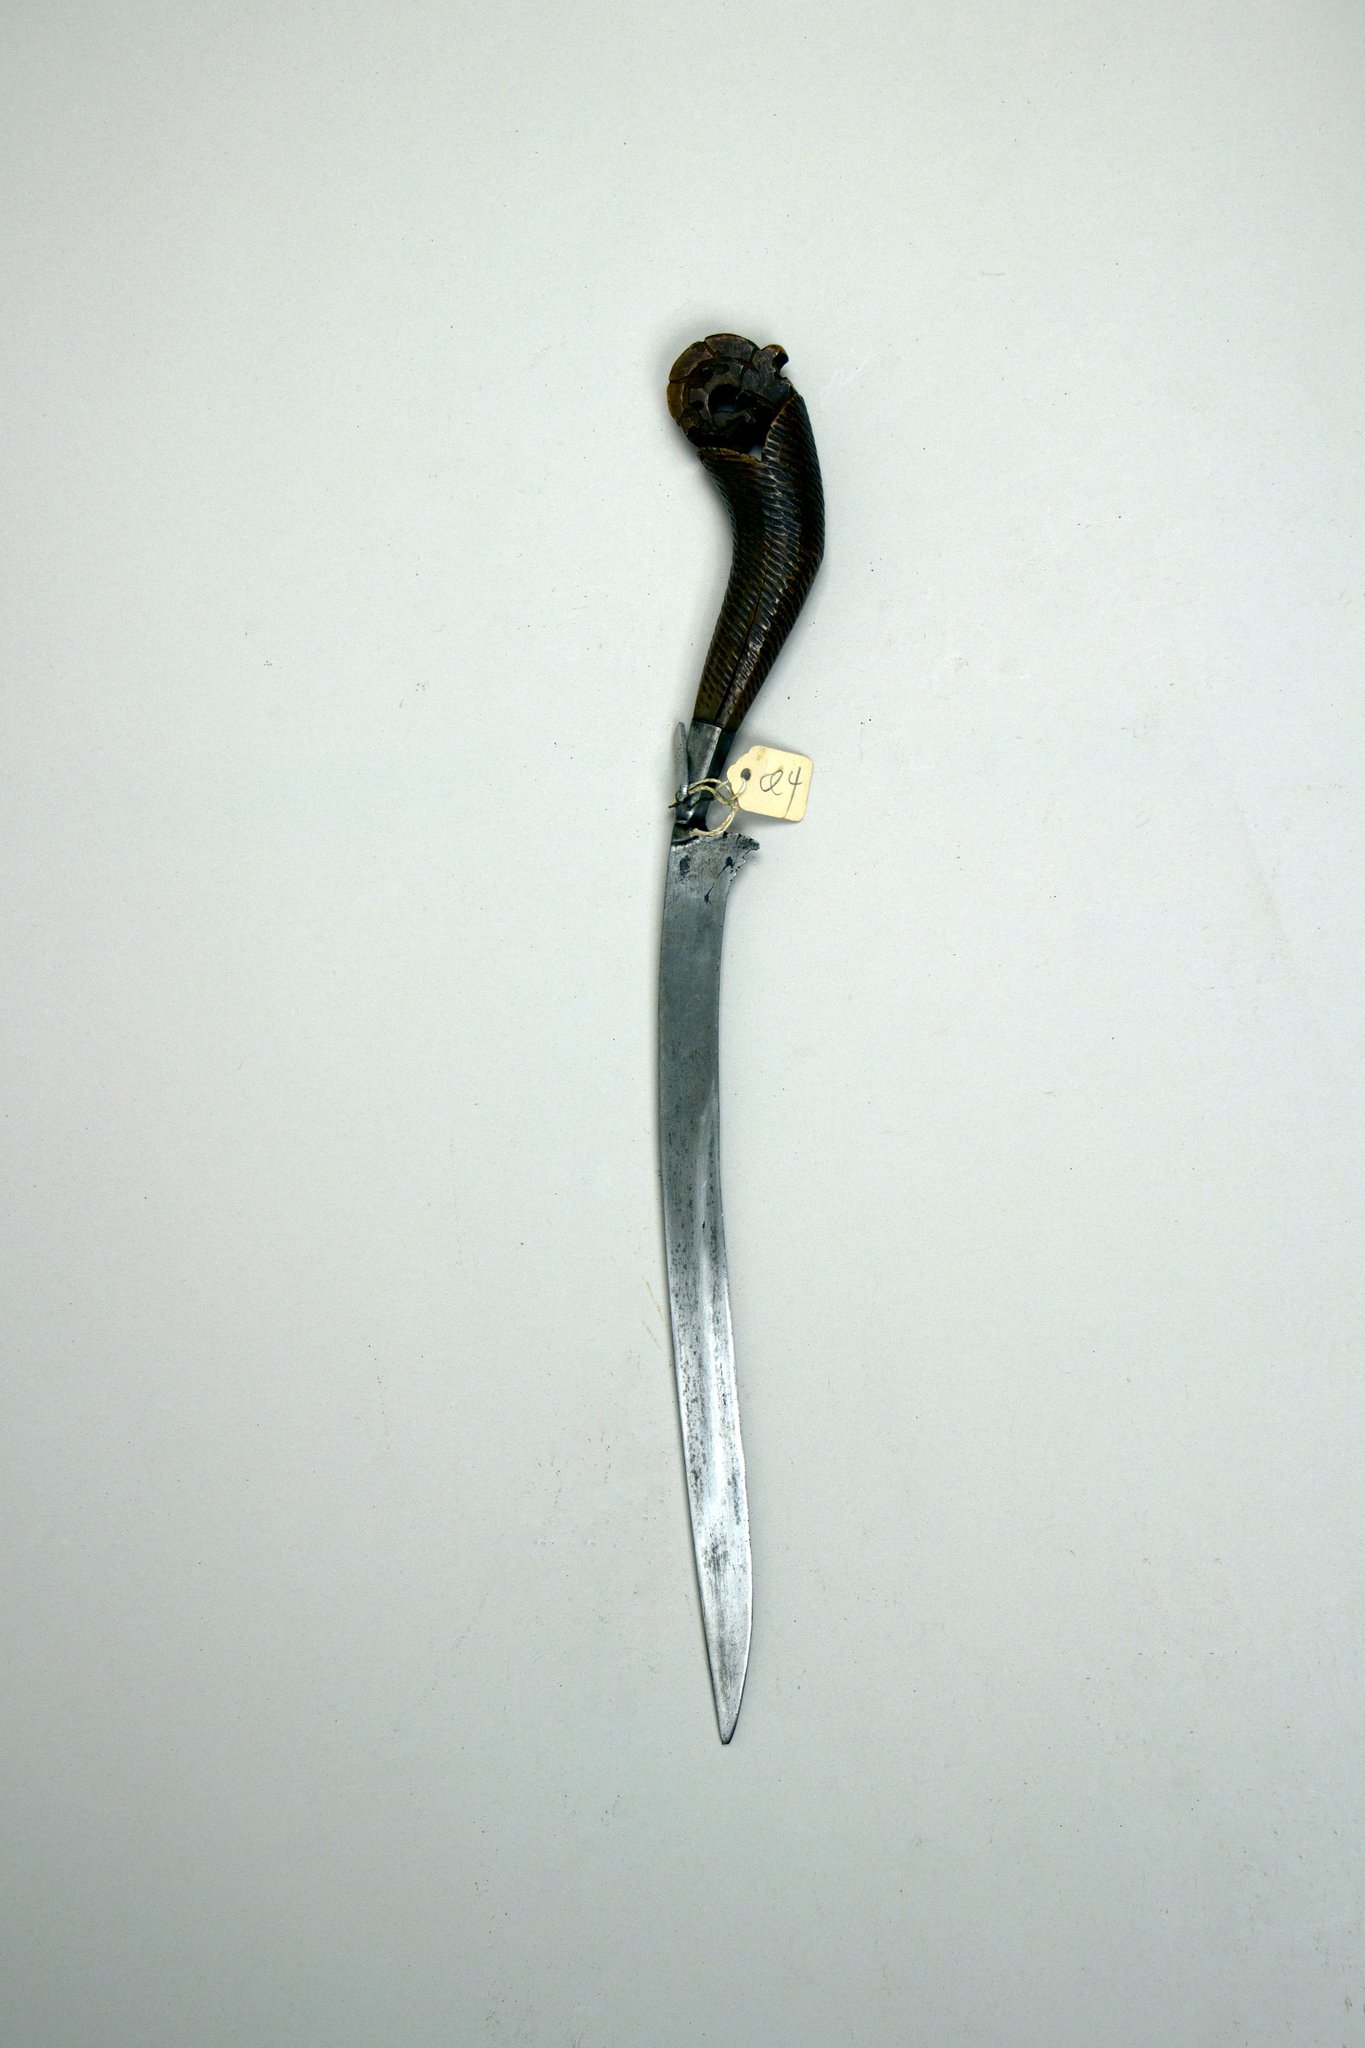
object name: knife bade bade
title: Knife (Bade-bade)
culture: sumatran or acheen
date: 1501-1900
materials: horn, steel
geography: indonesia